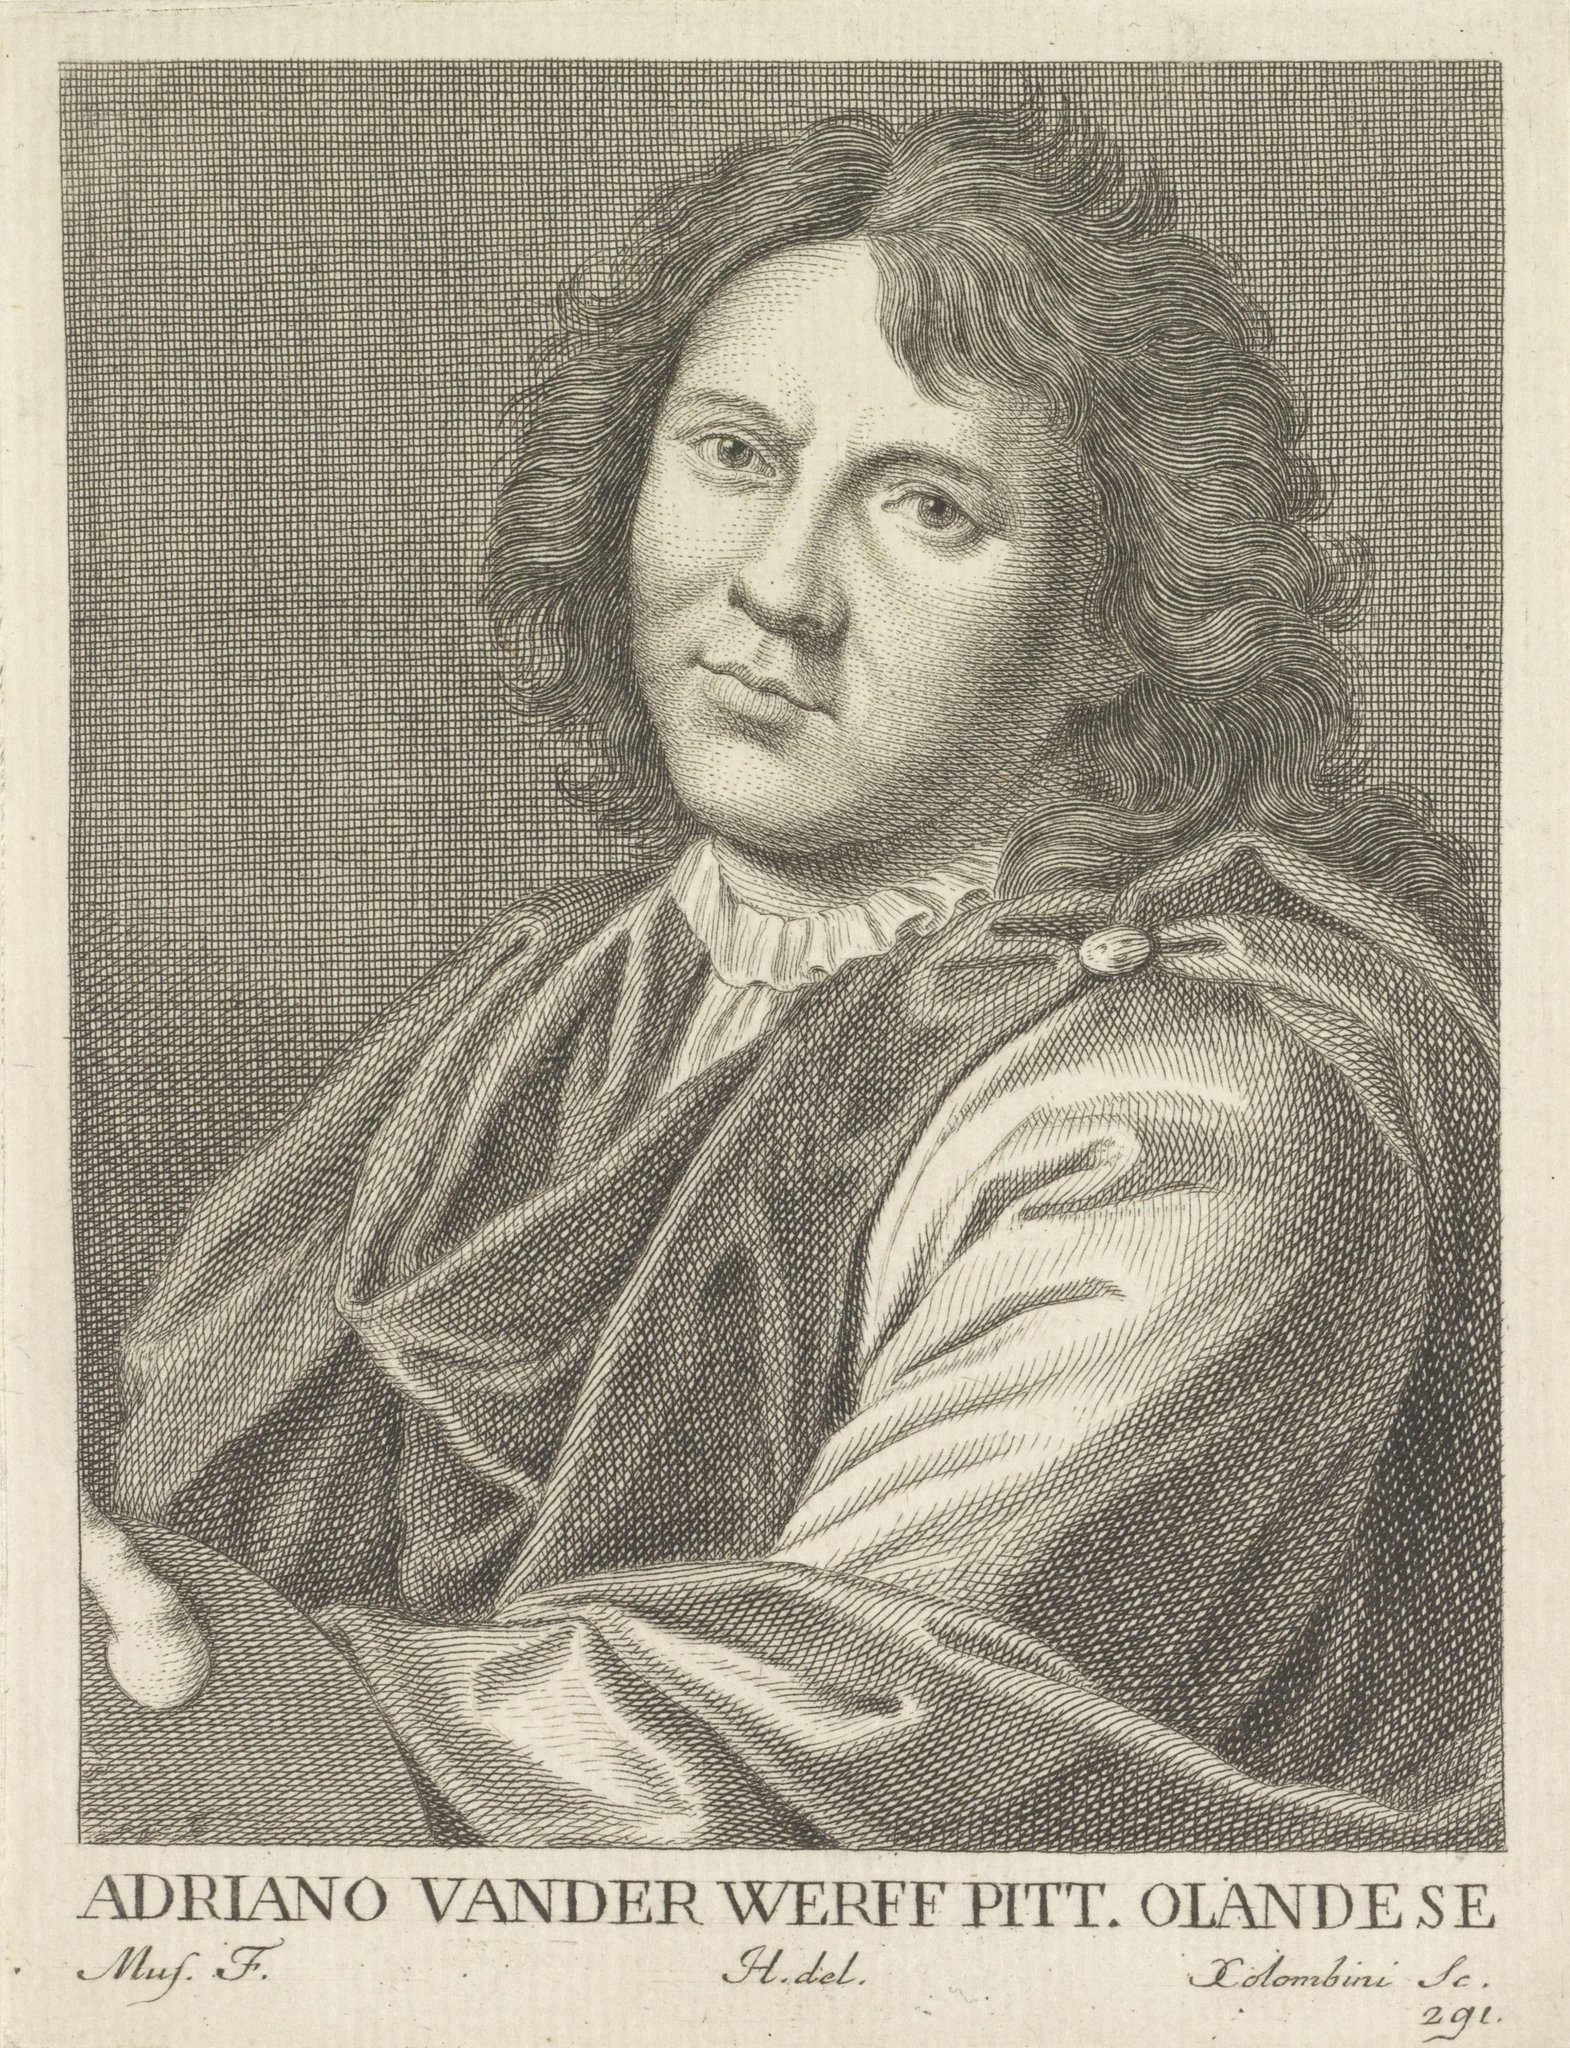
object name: print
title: Portret van kunstenaar Adriaen van der Werff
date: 1769-1775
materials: paper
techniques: engraving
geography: italy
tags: rotterdam, painter, adriaen van der werff, historical persons, portrait, self-portrait of artist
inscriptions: collector's mark: Lugt 2228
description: Prent gebruikt voor Pacini, Sante, Serie degli Uomini i più illustri nella pittura, scultura e architettura (12 vols.), Florence 1769-1775. Ieder deel is onderverdeeld in verschillende hoofdstukken, elk bestaande uit de lofrede op een kunstenaar voorafgegaan door een gegraveerde portret van de deze kunstenaar.